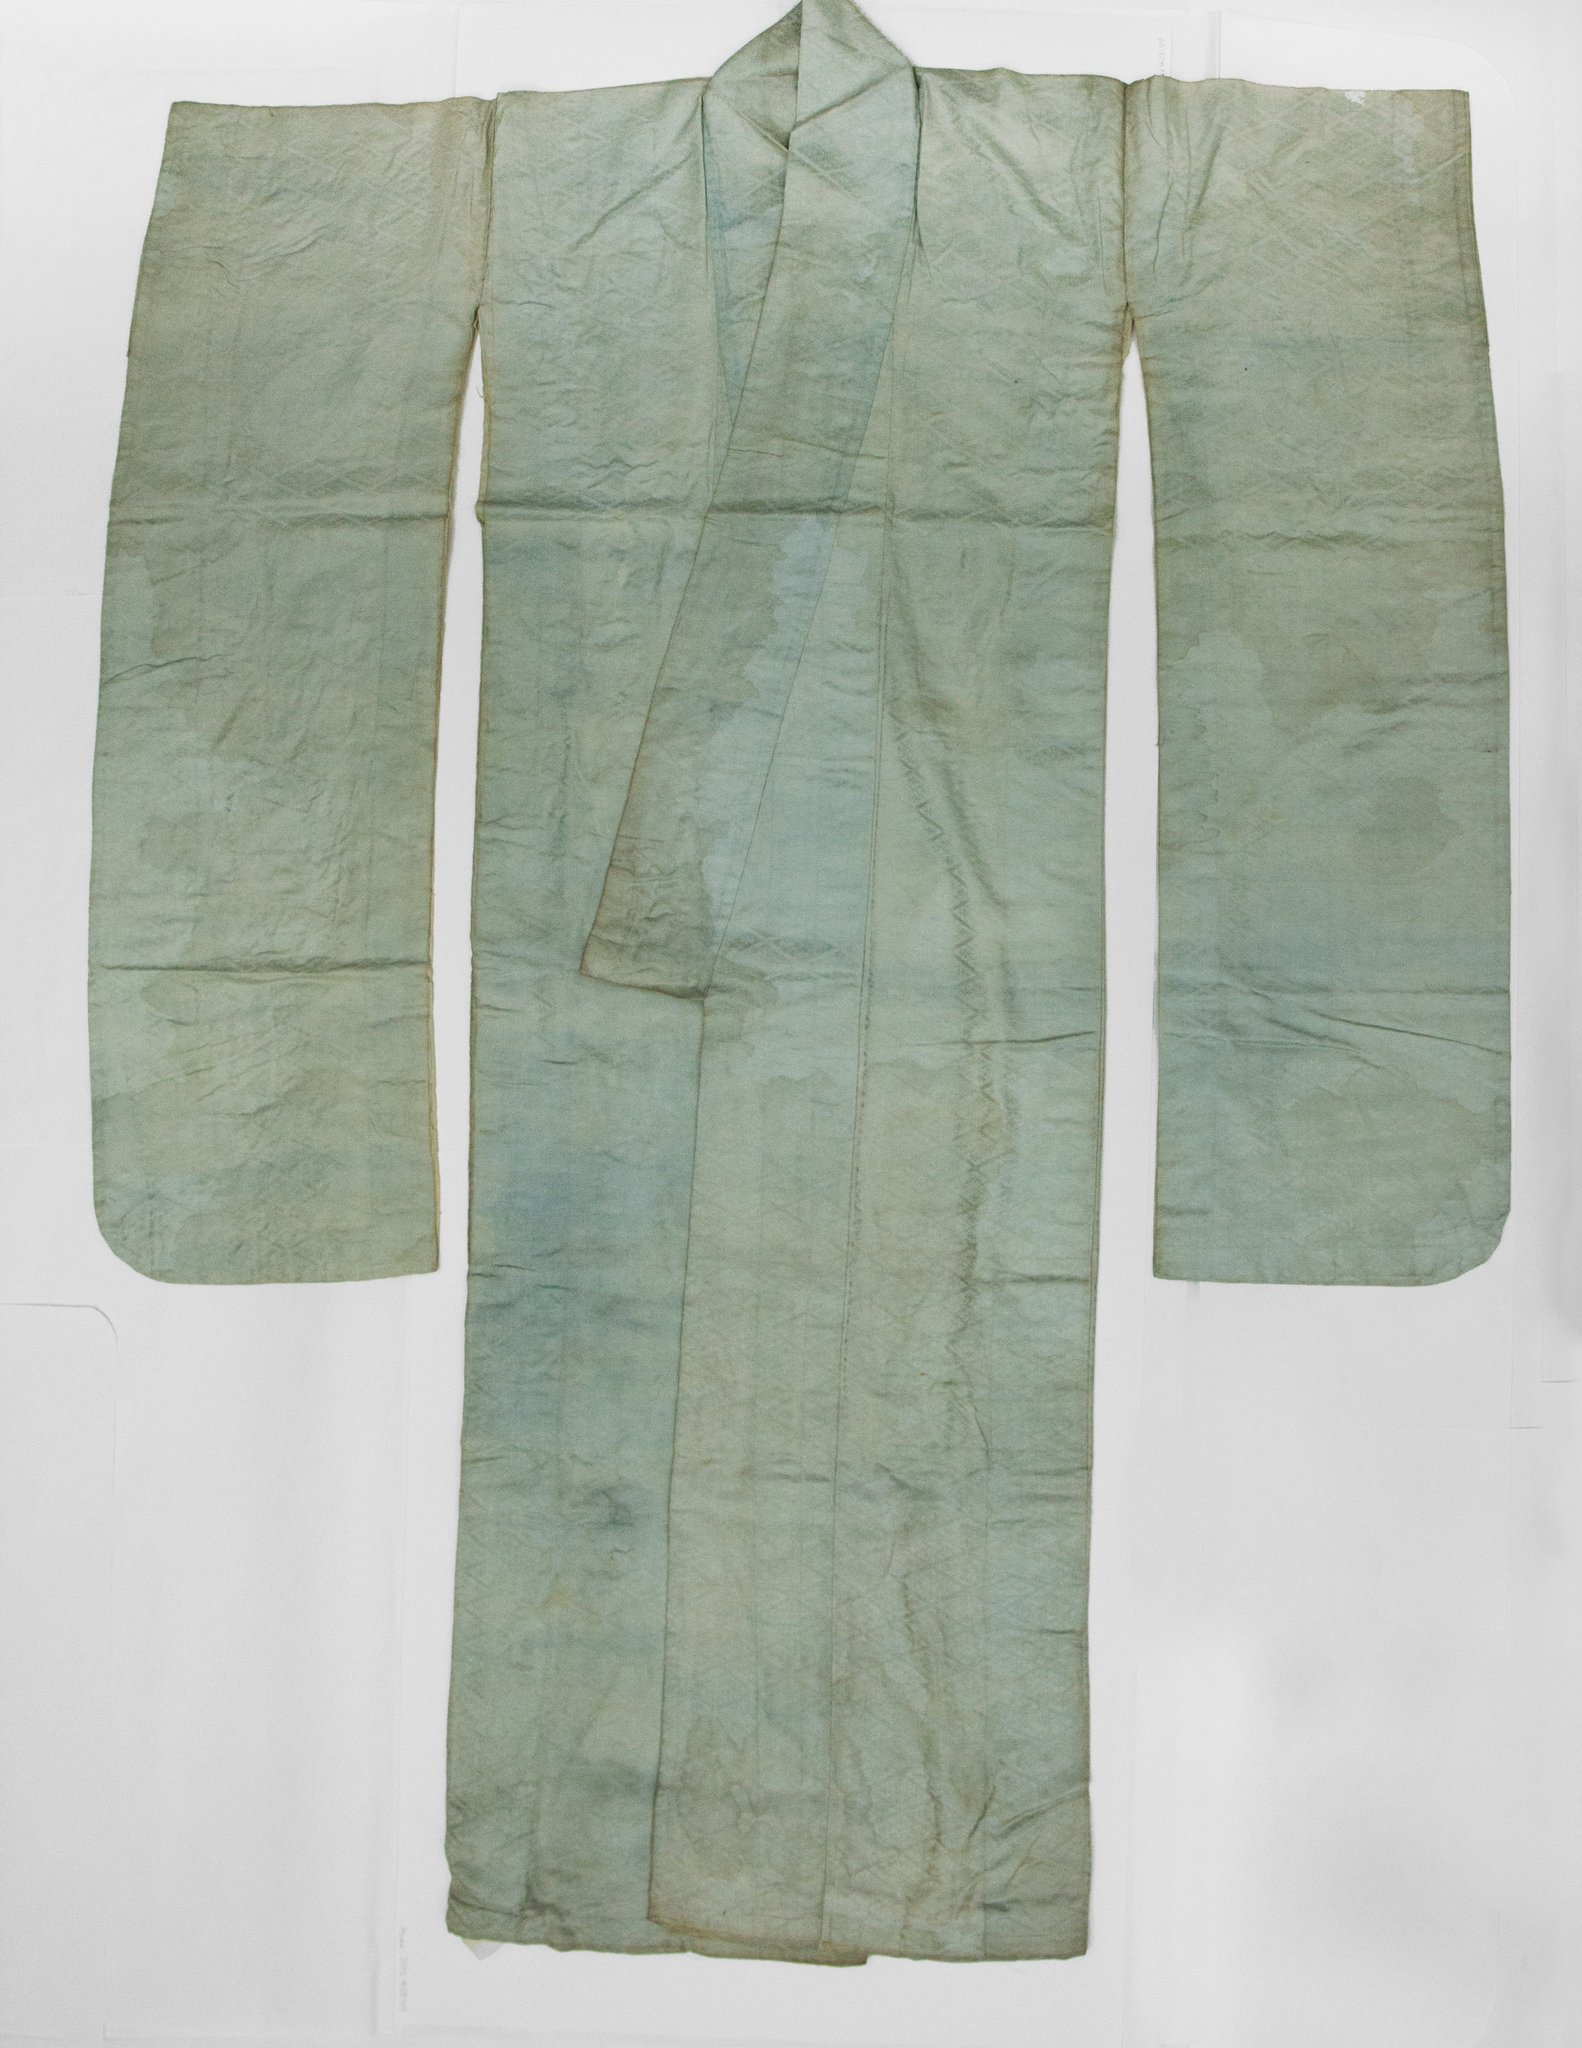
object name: robe with long swinging sleeve furisode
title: Robe with Long Swinging Sleeves (Furisode)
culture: japanese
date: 1615-1868